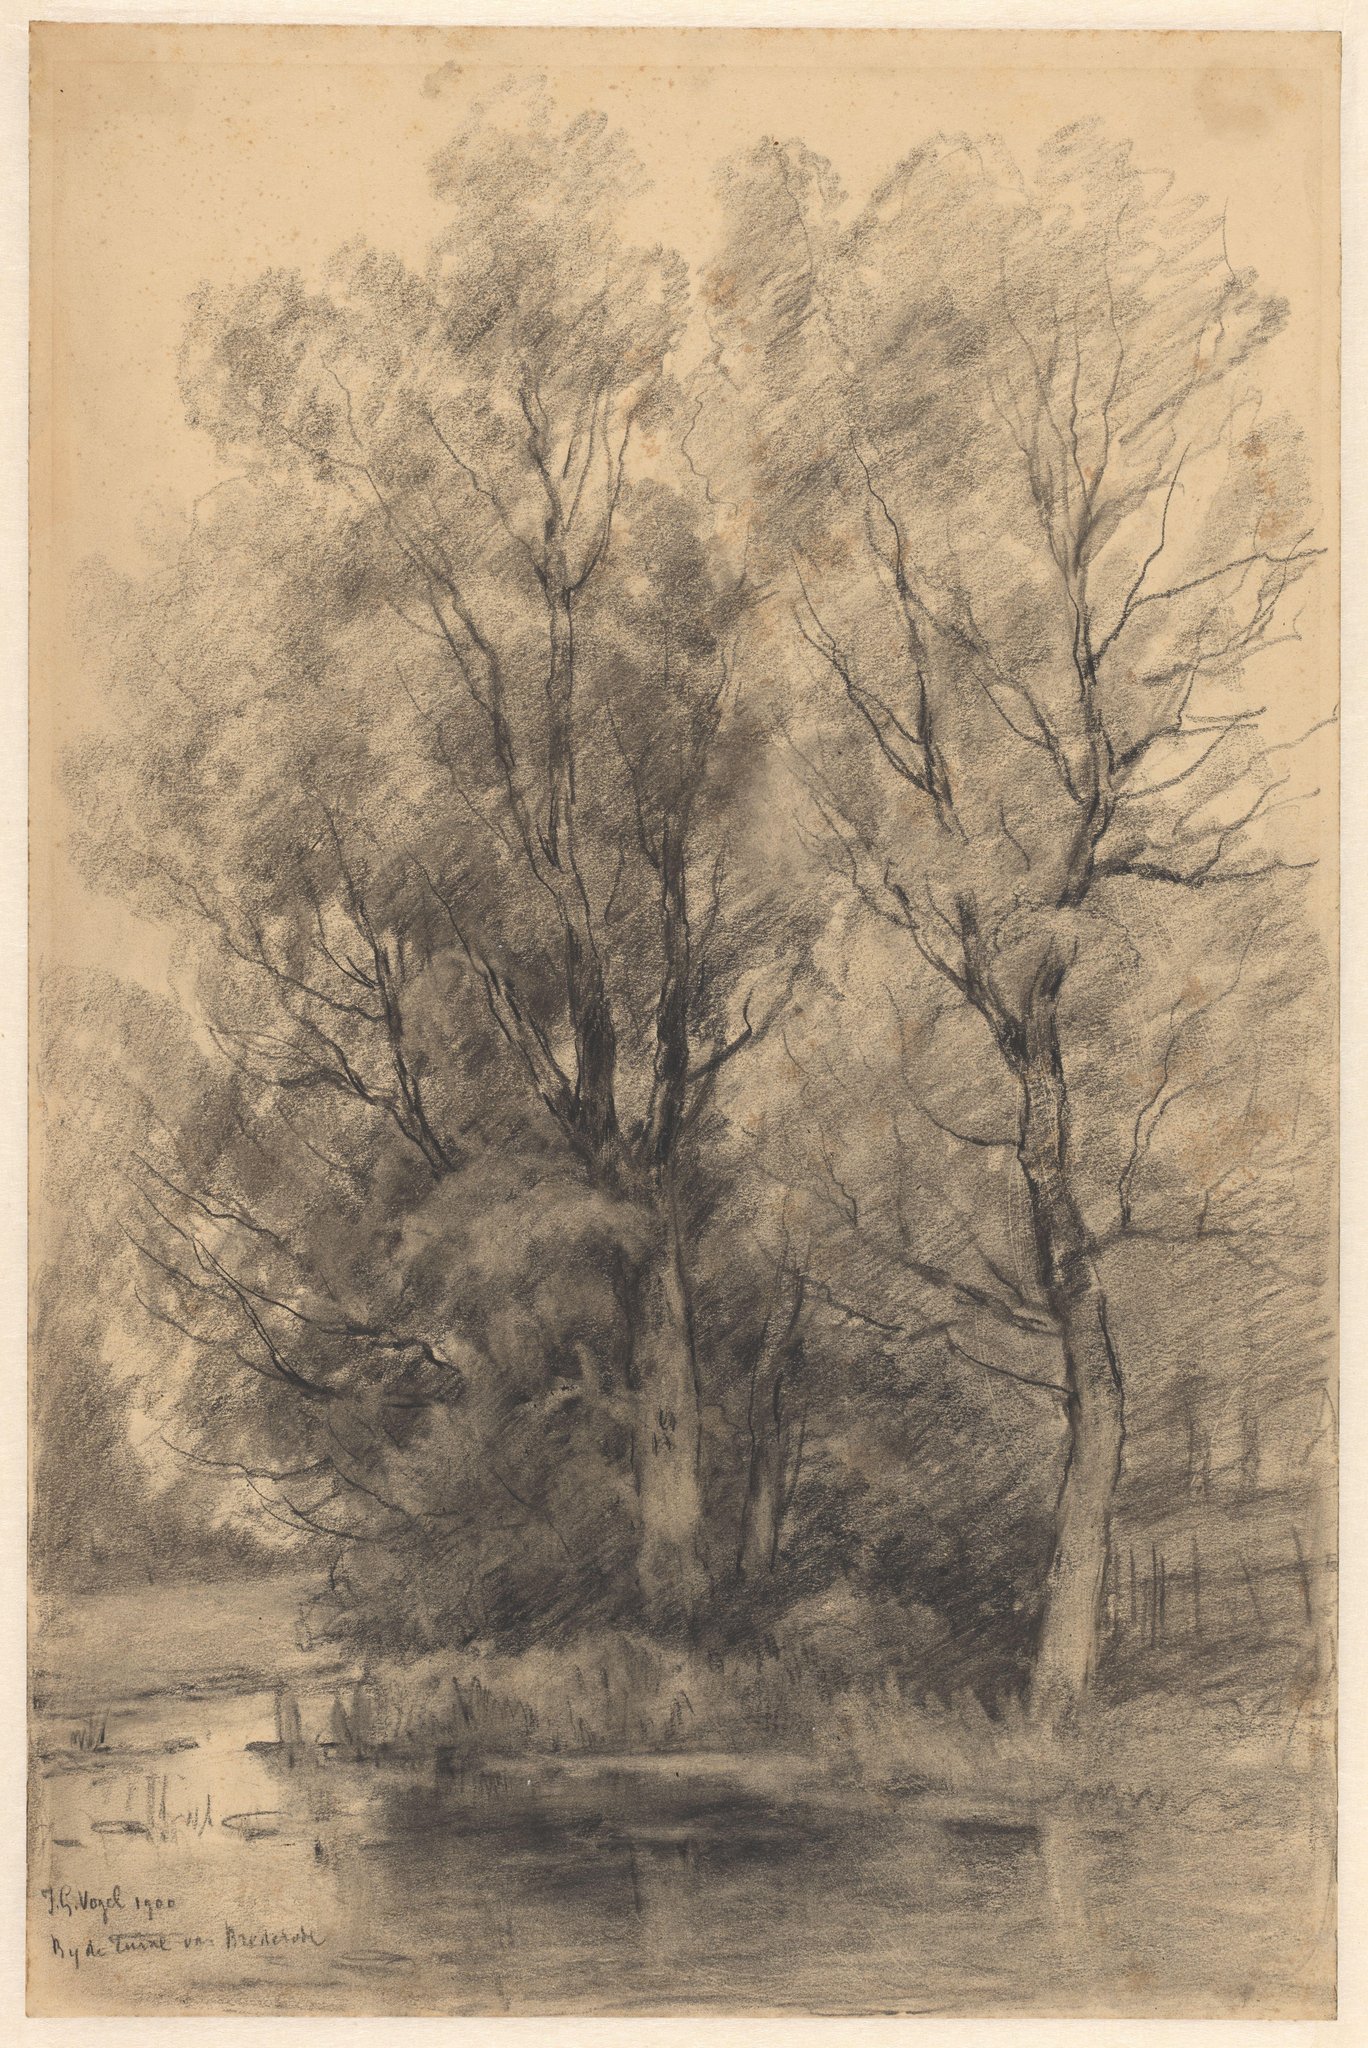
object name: drawing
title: Bomen langs een waterkant bij de ruïne van Brederode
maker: johannes gijsbert vogel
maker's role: draughtsman, painter, print maker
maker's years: 1828-1915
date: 1900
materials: chalk, paper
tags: trees, landscapes with waters, waterscapes, seascapes (in the temperate zone)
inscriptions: date and inscription: ‘1900/ Bij de ruïne van Brederode’, collector's mark: Lugt 1181b